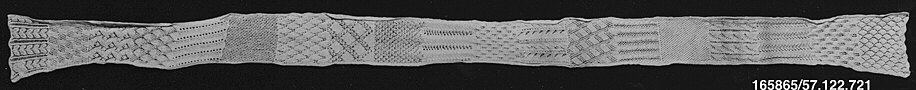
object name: sampler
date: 1801-1900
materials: lace, wool